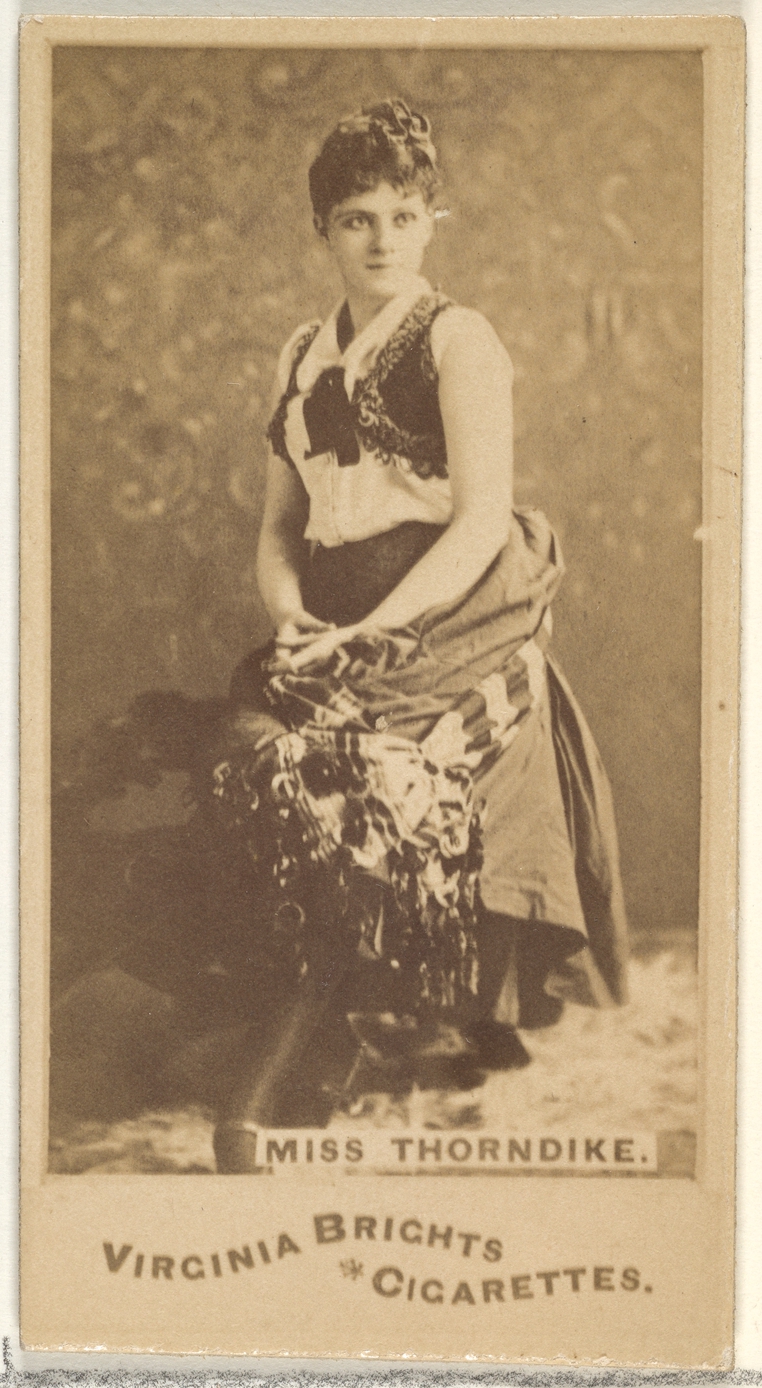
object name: photograph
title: Miss Thorndike, from the Actors and Actresses series (N45, Type 1) for Virginia Brights Cigarettes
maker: allen & ginter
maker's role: publisher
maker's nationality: american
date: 1888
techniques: albumen silver print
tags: portraits,women